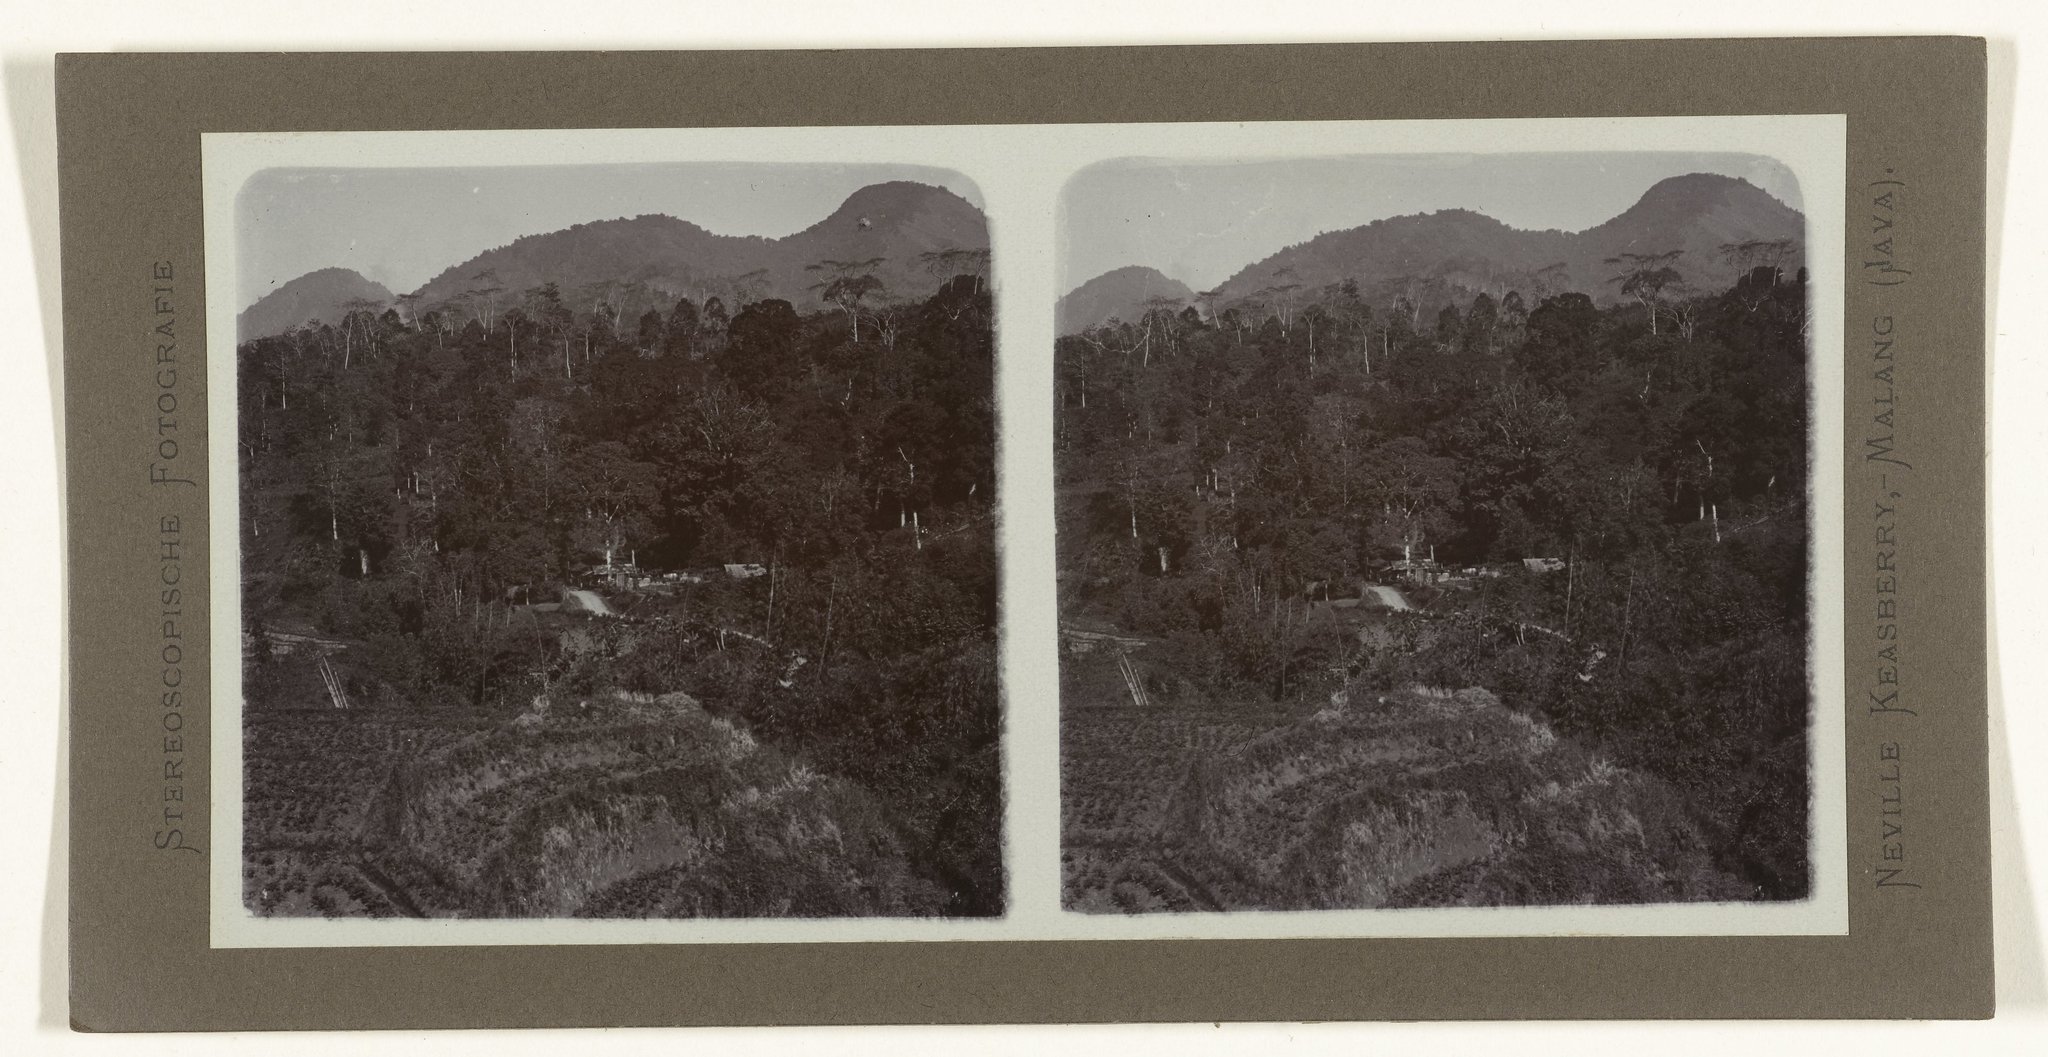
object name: stereograph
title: Berggezicht op de gunung Kawi vanuit de dicht beboste vallei van Malang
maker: neville keasberry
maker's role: fotograaf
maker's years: 1866-1944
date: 1900-1935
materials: cardboard, paper, photographic support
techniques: albumen print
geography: malang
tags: malang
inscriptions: inscription: ‘Stereoscopische Fotografie’, signature: ‘Neville Keasberry, Malang (Java)’